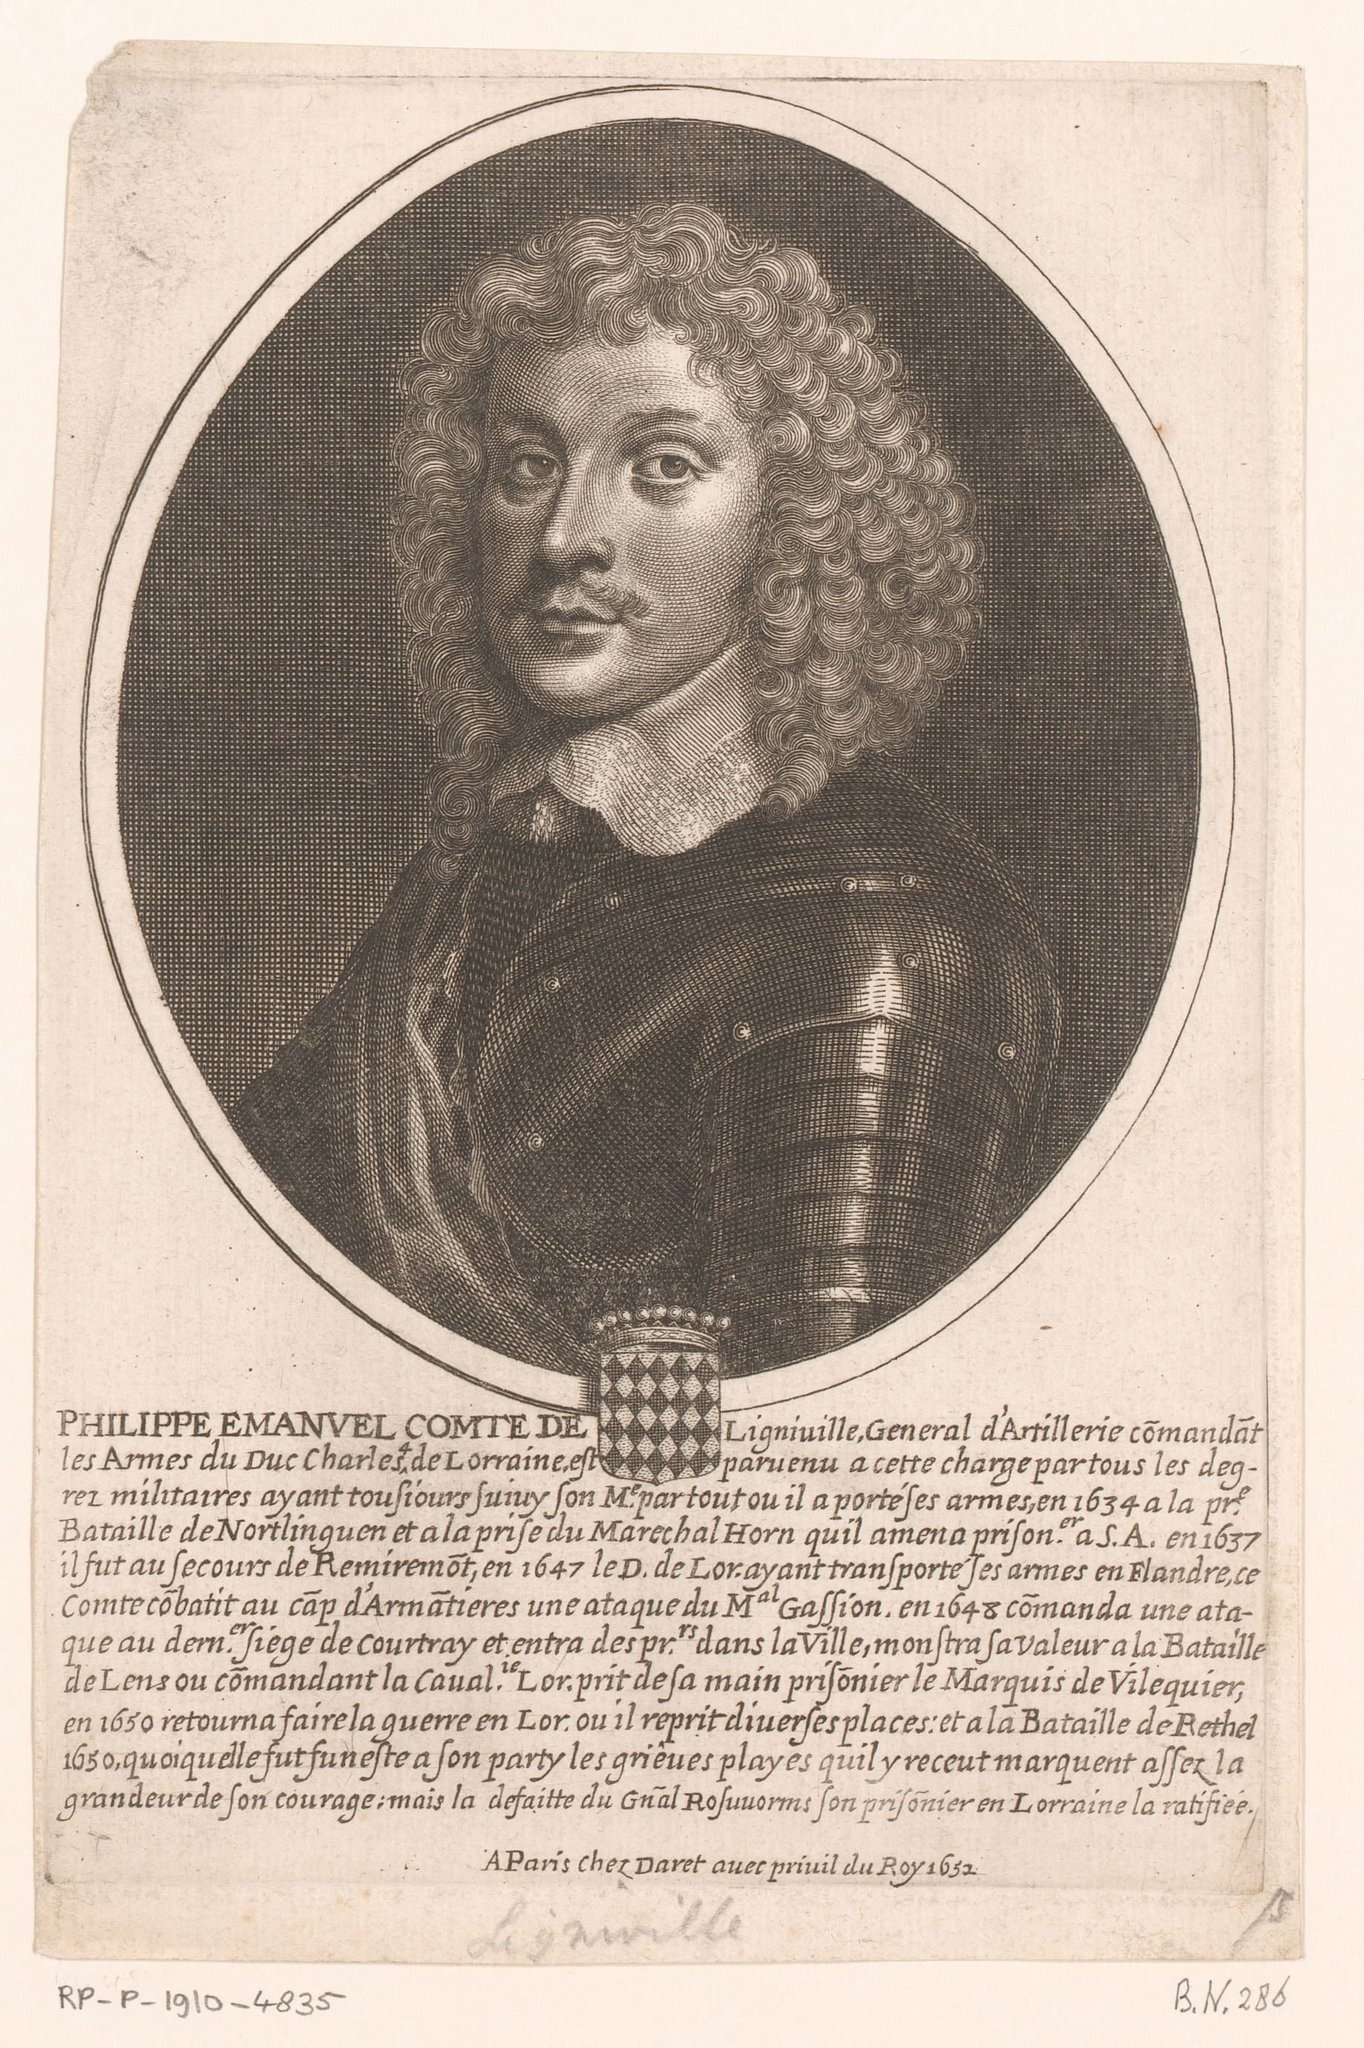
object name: print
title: Portretten van bekende historische figuren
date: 1652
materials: paper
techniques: engraving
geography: france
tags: earl, historical persons, armorial bearing, heraldry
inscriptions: collector's mark: Lugt 2228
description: Maakt deel uit van een serie portretten getiteld 'Tableaux historiques ou sont gravez les Illustres François et Etrangiers de l'un et l'autre sexe (...)', voor het eerst uitgegeven in 1652 door Daret. Een tweede staat werd uitgegeven door Boissevin en een derde door Jollain.